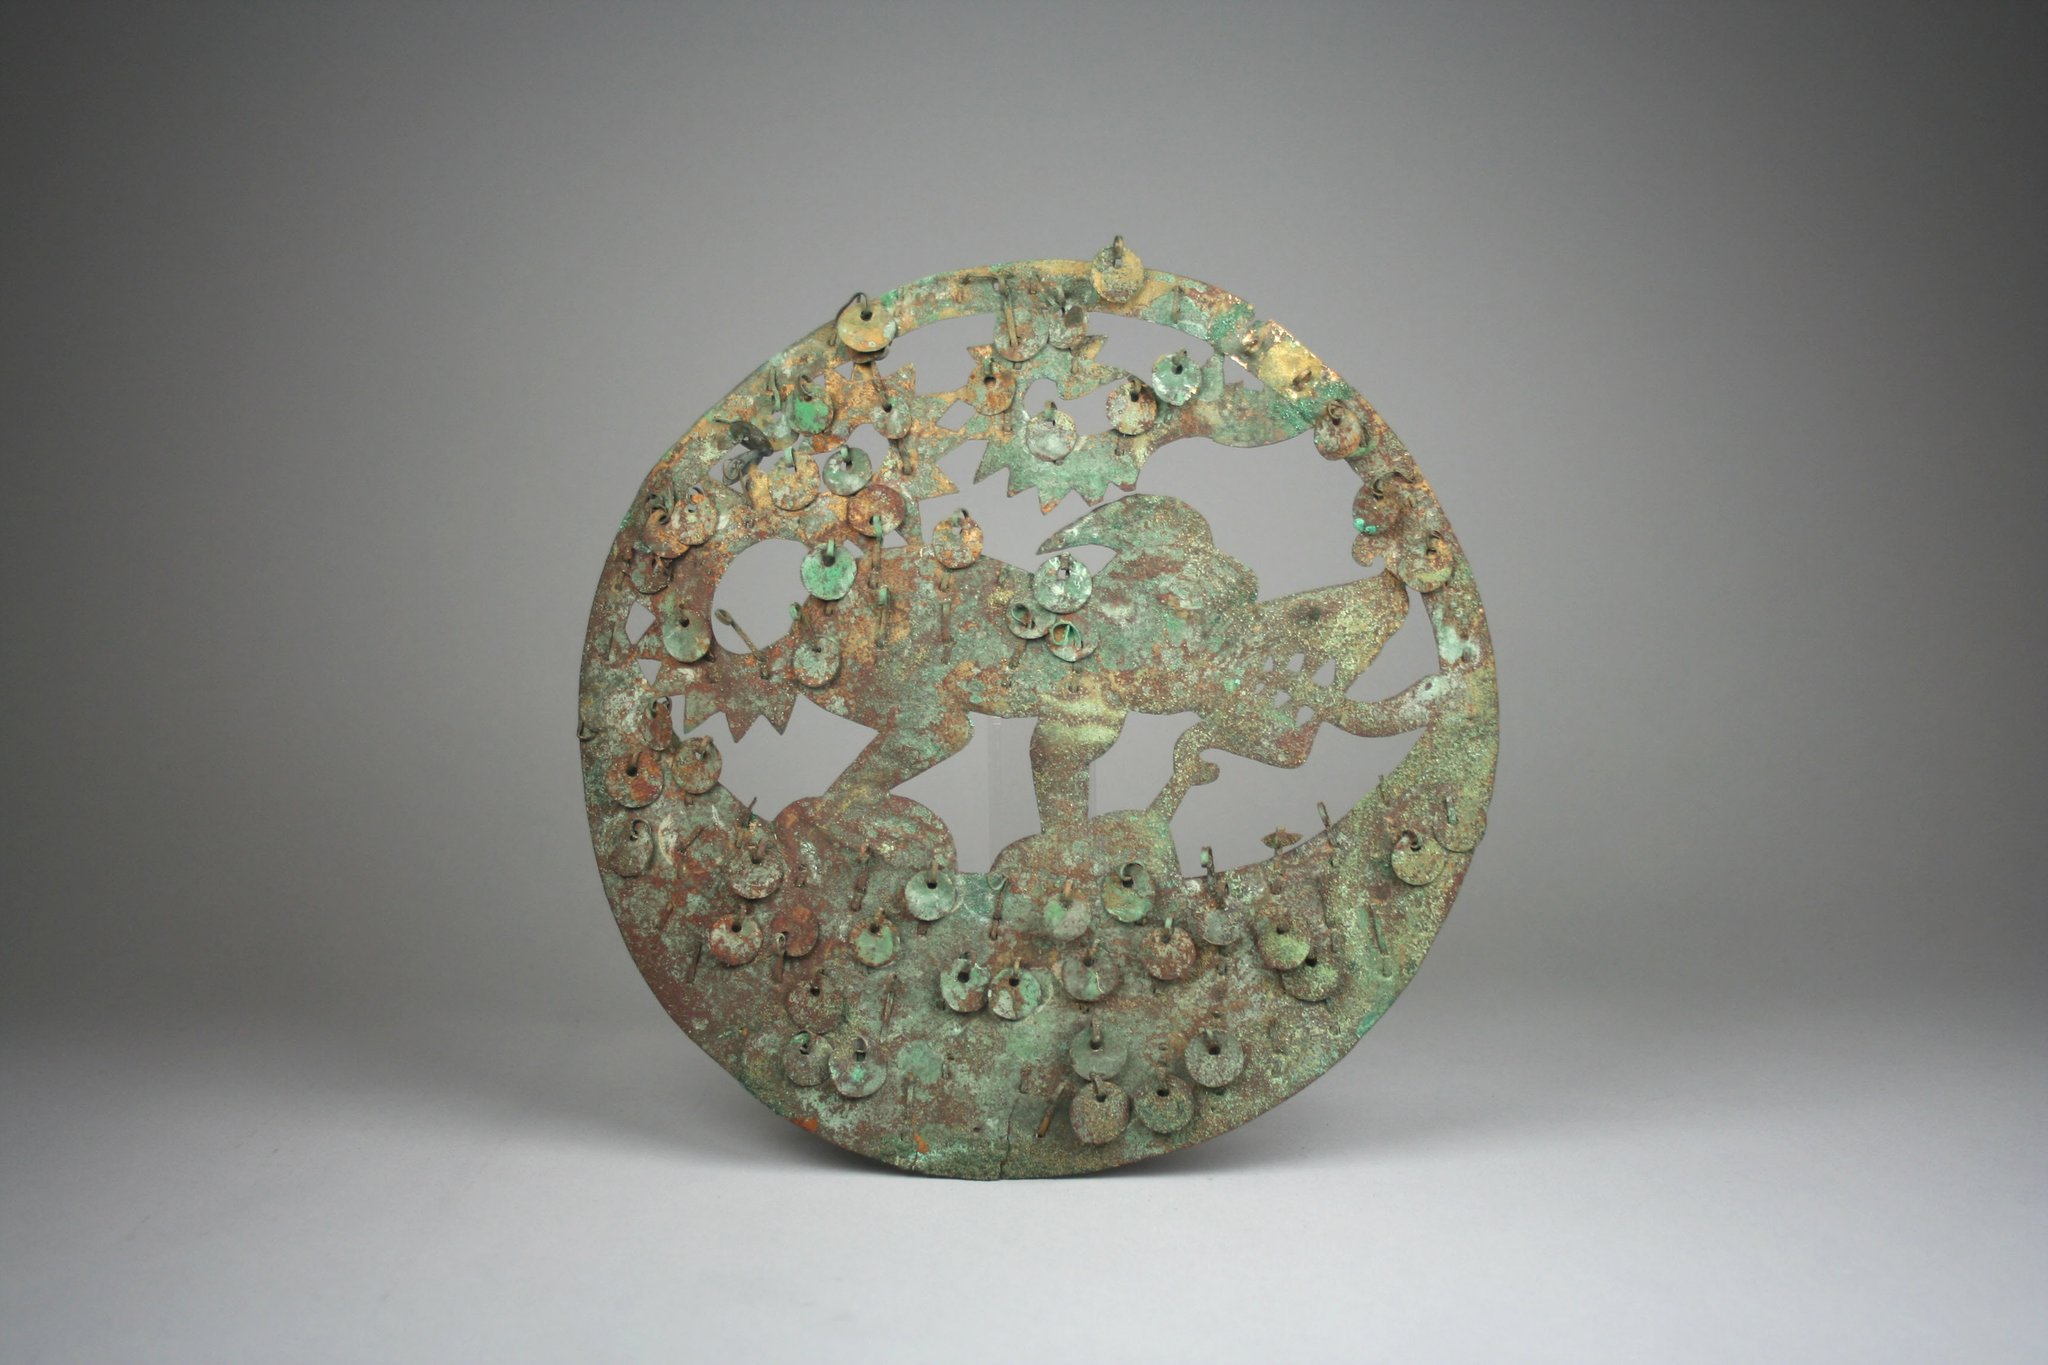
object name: ornament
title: Cutout Disk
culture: moche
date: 501-700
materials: gilt copper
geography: peru